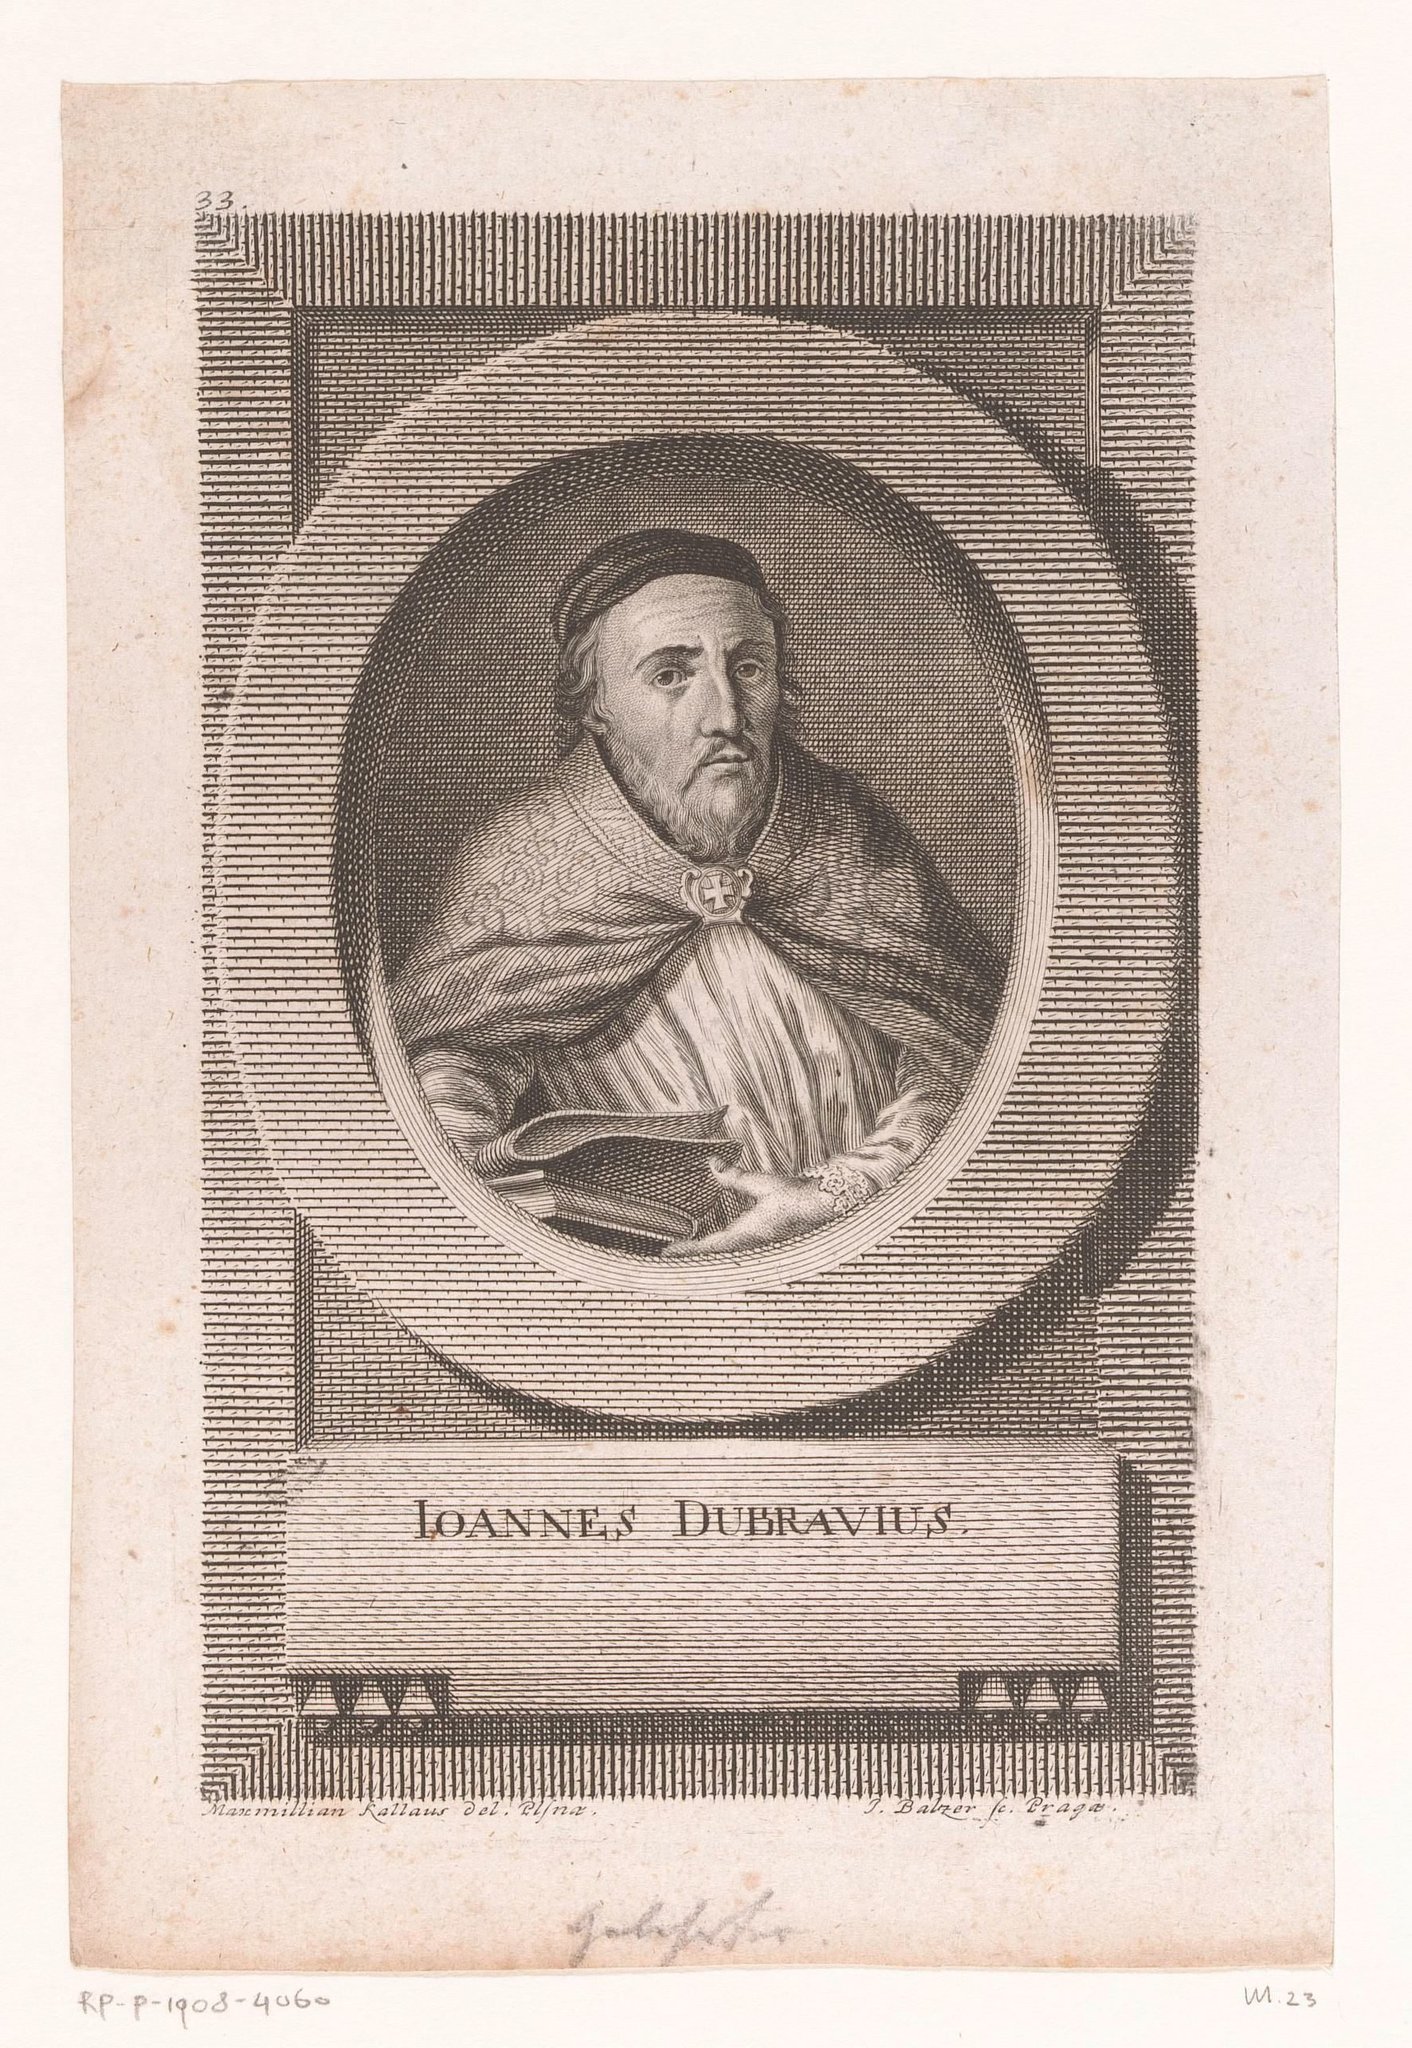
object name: print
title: Portret van Johannes Dubravius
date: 1746-1799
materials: paper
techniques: engraving, etching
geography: prague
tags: historical persons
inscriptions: collector's mark: Lugt 2228